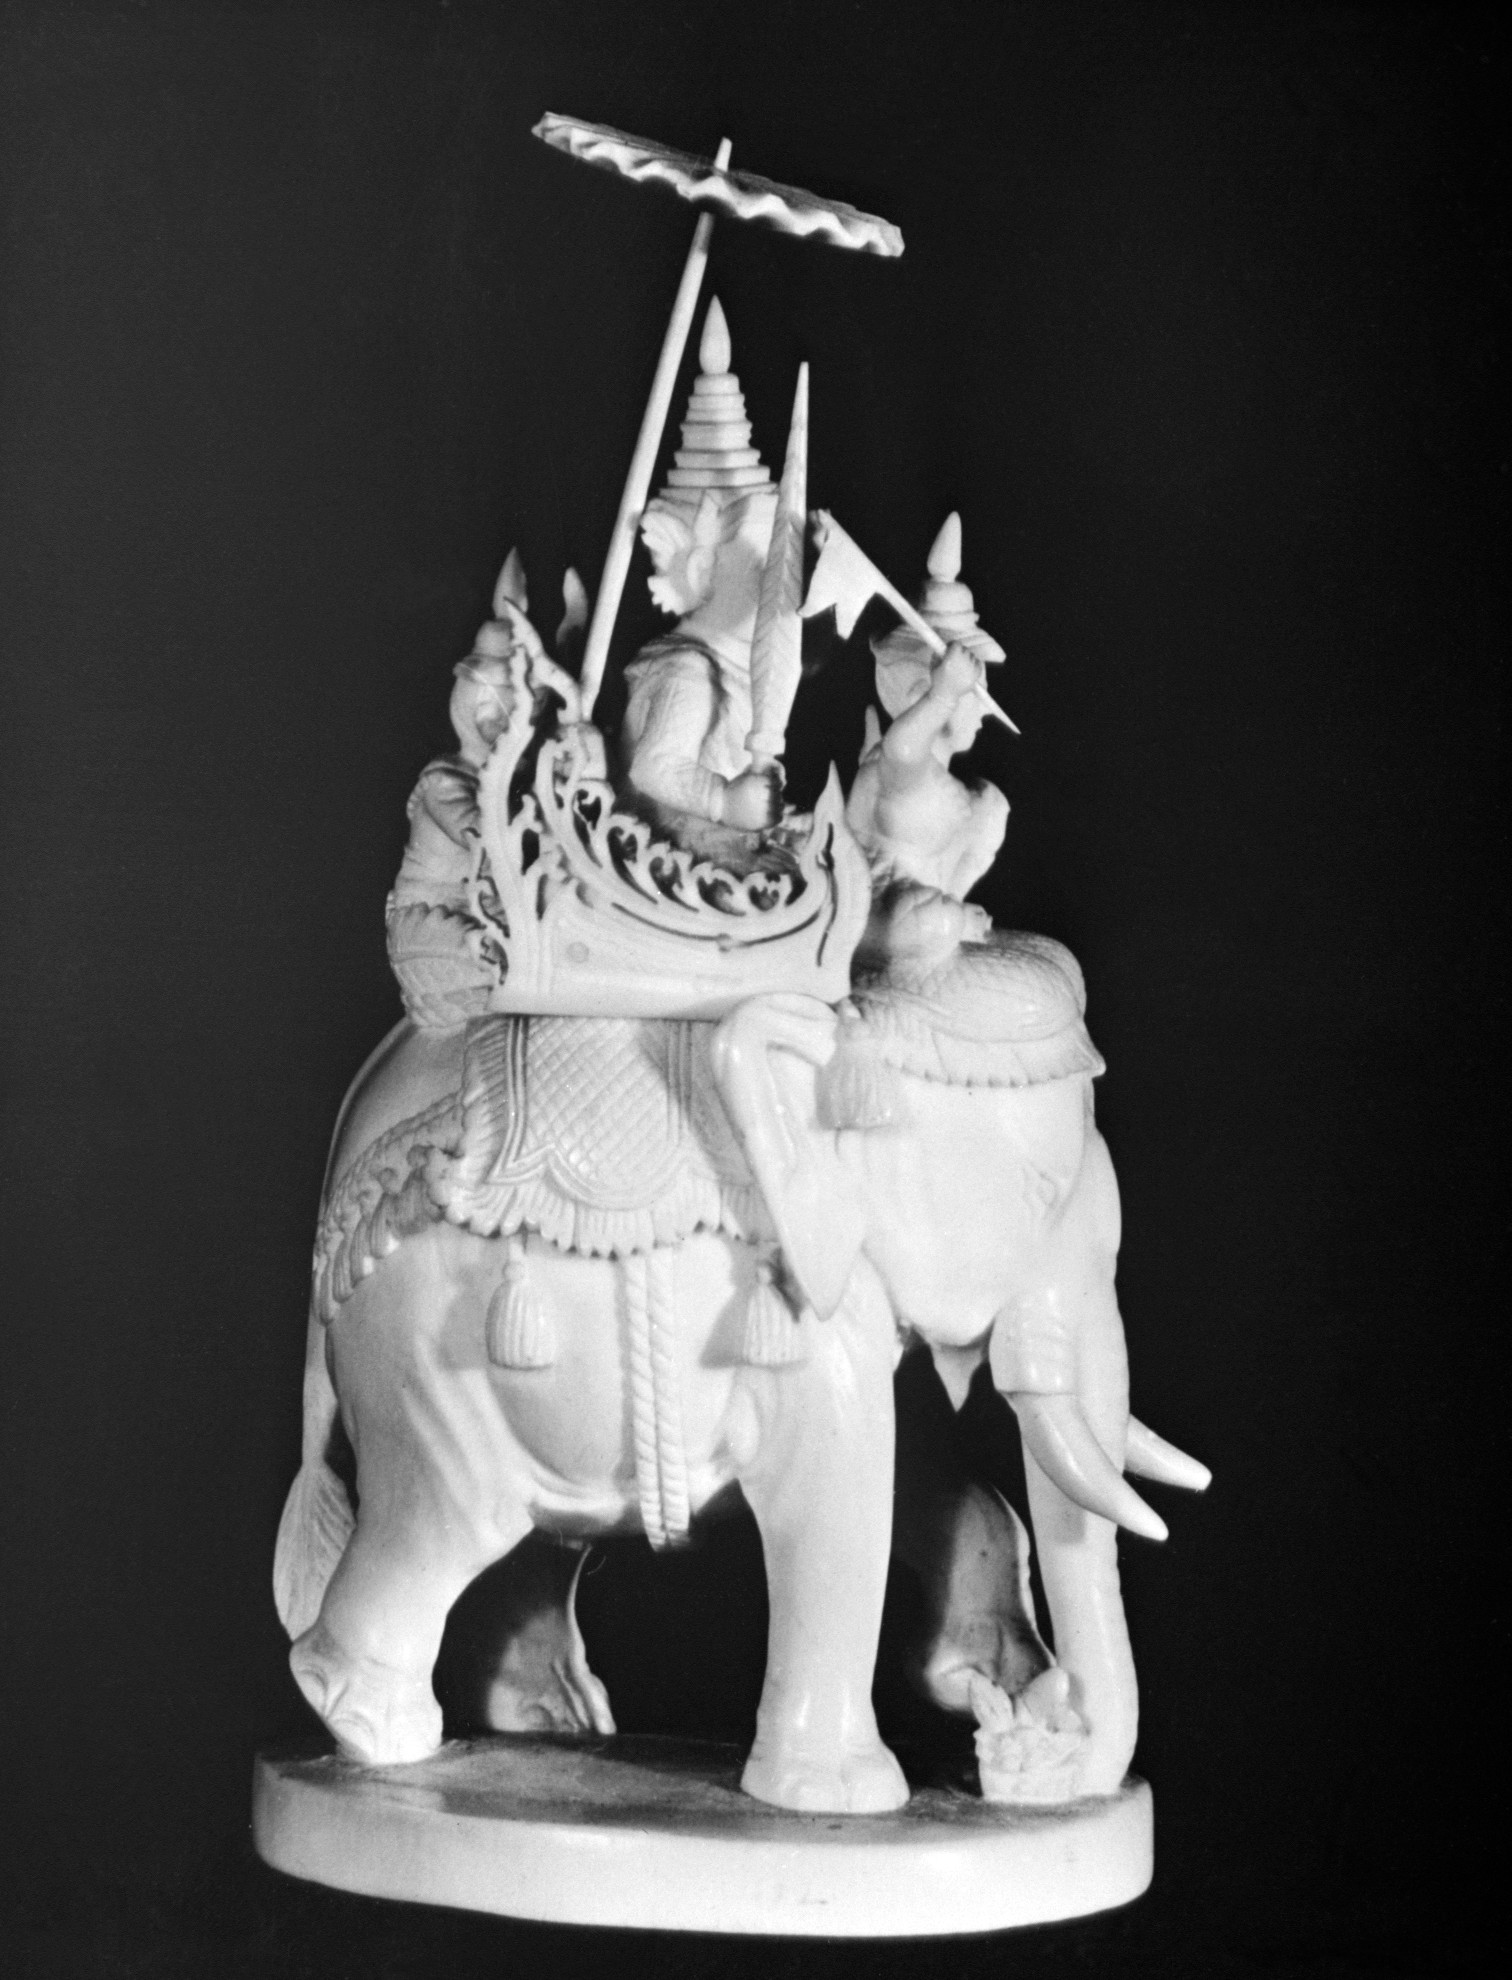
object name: chessman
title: Chessman (King)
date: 1801-1900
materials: ivory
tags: kings,chess,elephants